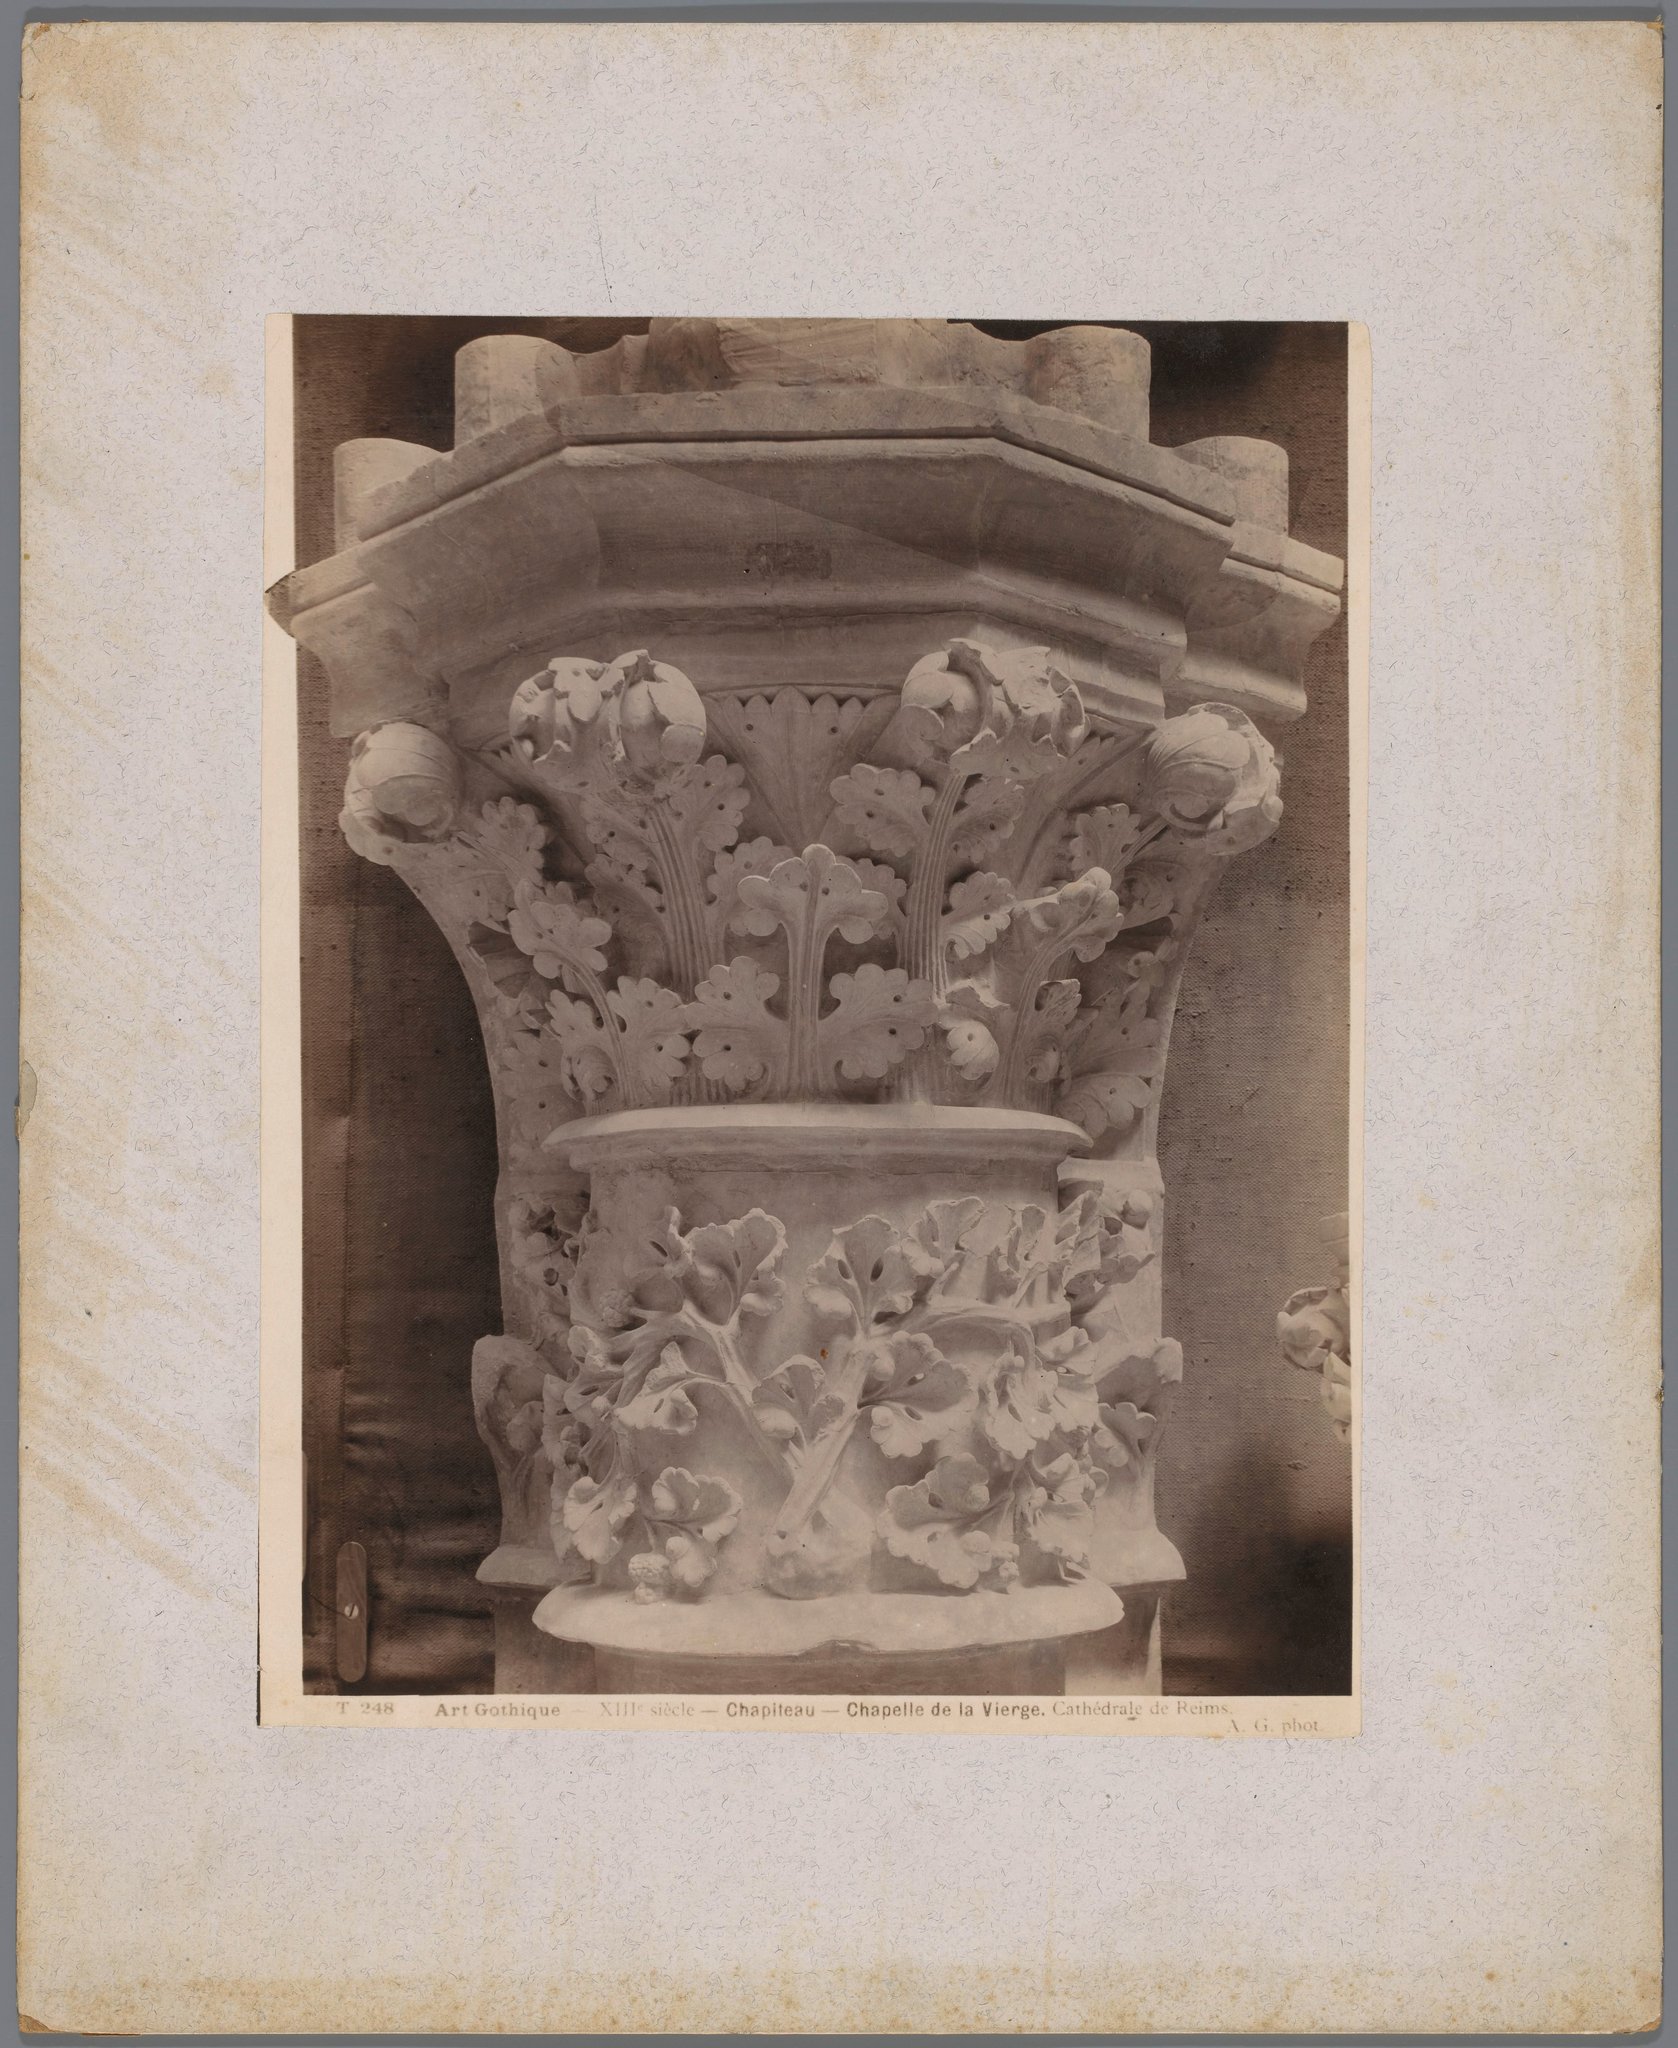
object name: photograph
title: Art Gothique XIII siècle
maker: adolphe giraudon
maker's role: publisher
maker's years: 1849-1929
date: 1850-1900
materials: cardboard, photographic support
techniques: albumen print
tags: capital (~ column, pillar)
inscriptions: inscription: ‘Cathédrale de Reims./ A.g. phot.’, collector's mark: ‘Rijks-normaalschool voor teekenonderwijzers amsterdam’, number: ‘T 248’, workshop stamp: ‘A. Giraudon/ Éditeur/ 15. R. Bonaparte. Paris’